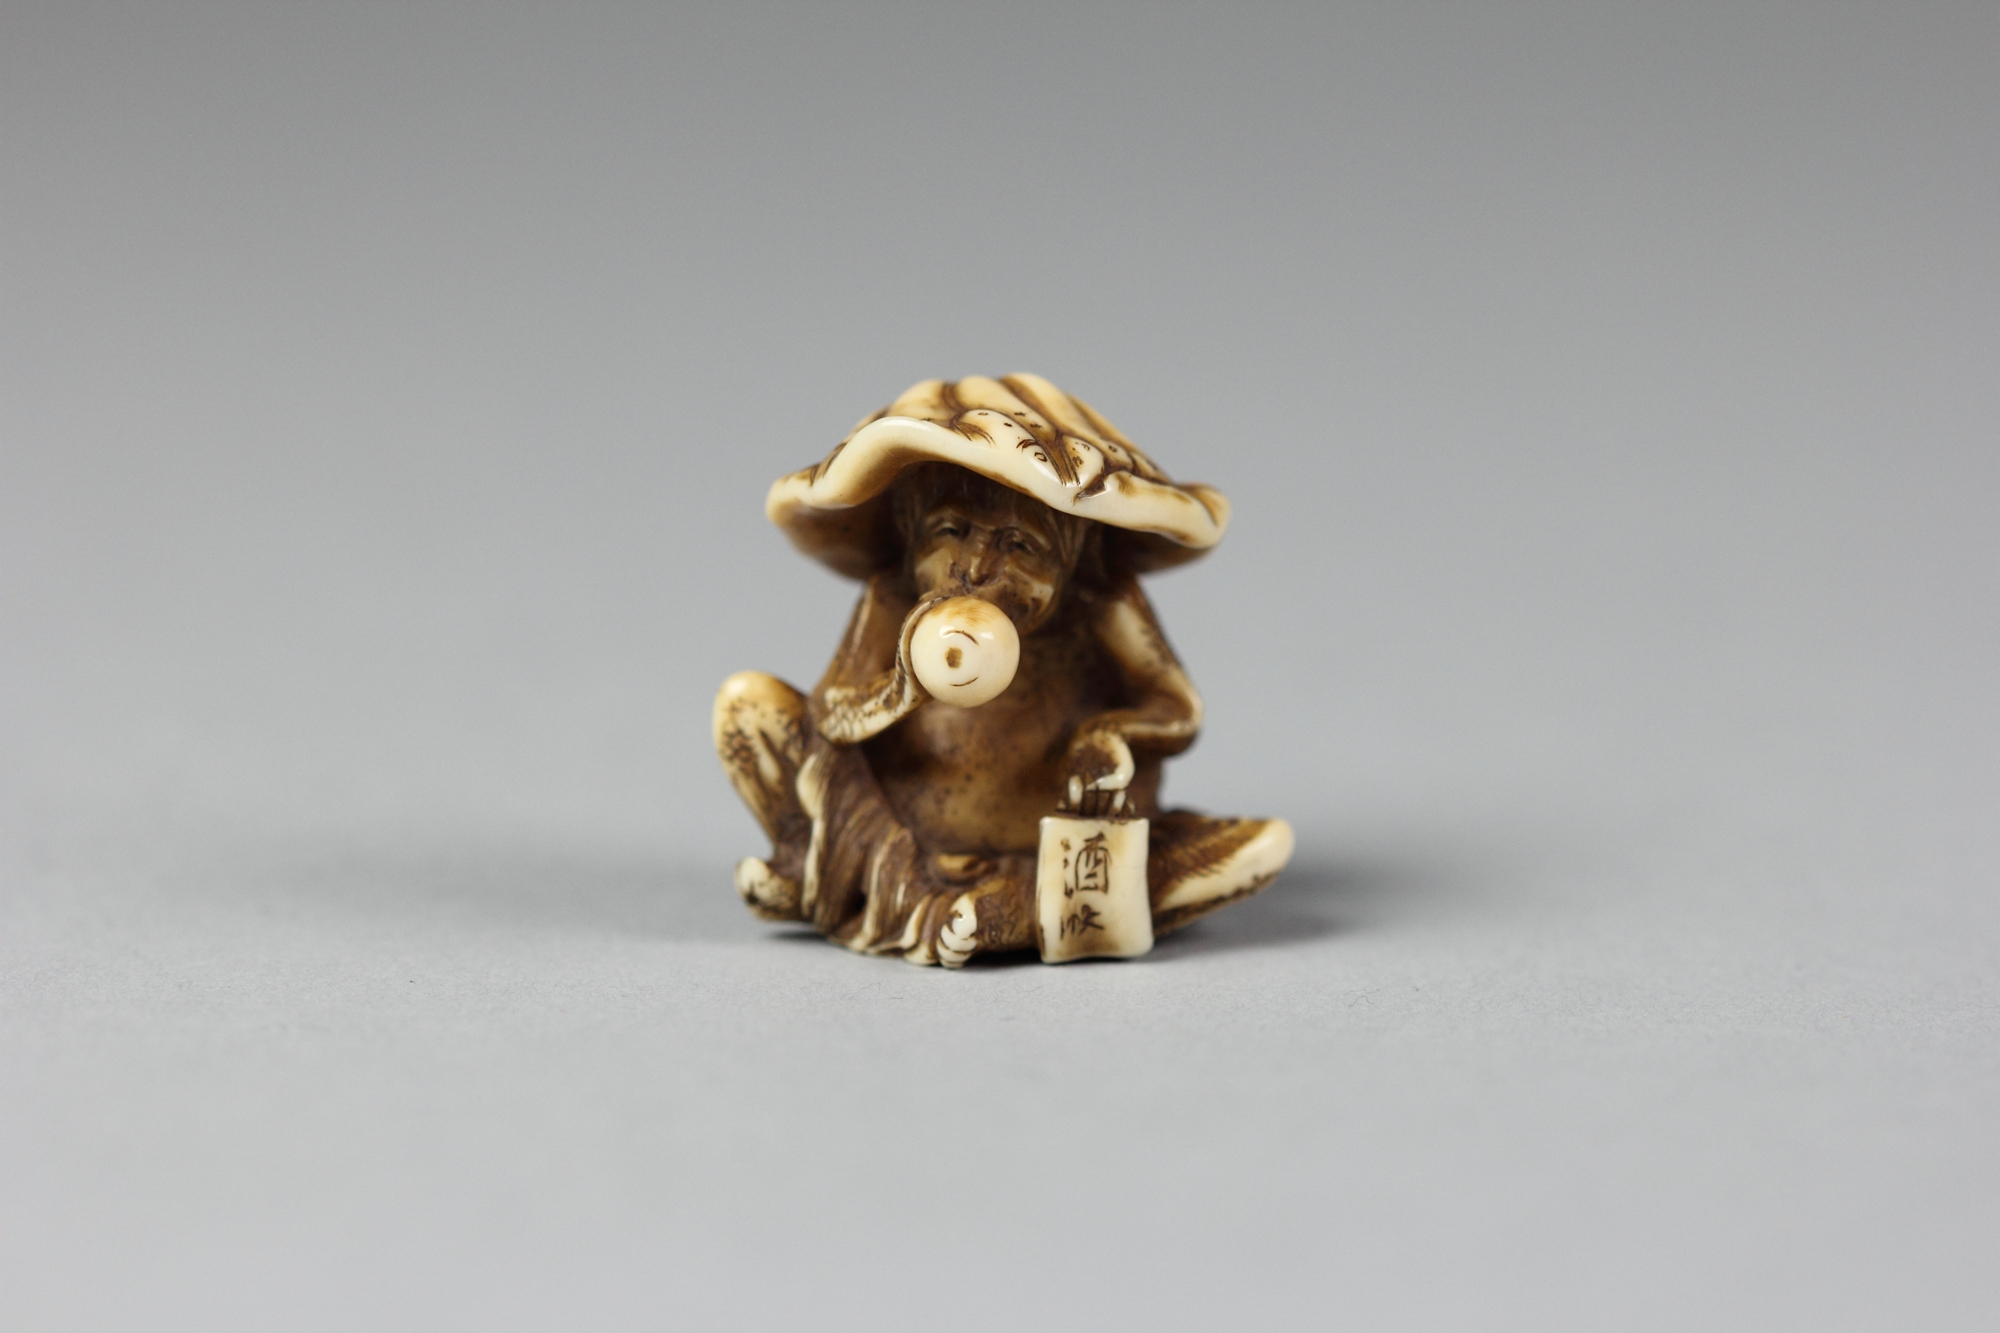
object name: netsuke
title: Netsuke of Monkey with Lotus Leaf Hat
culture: japanese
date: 1801-1900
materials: ivory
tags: monkeys